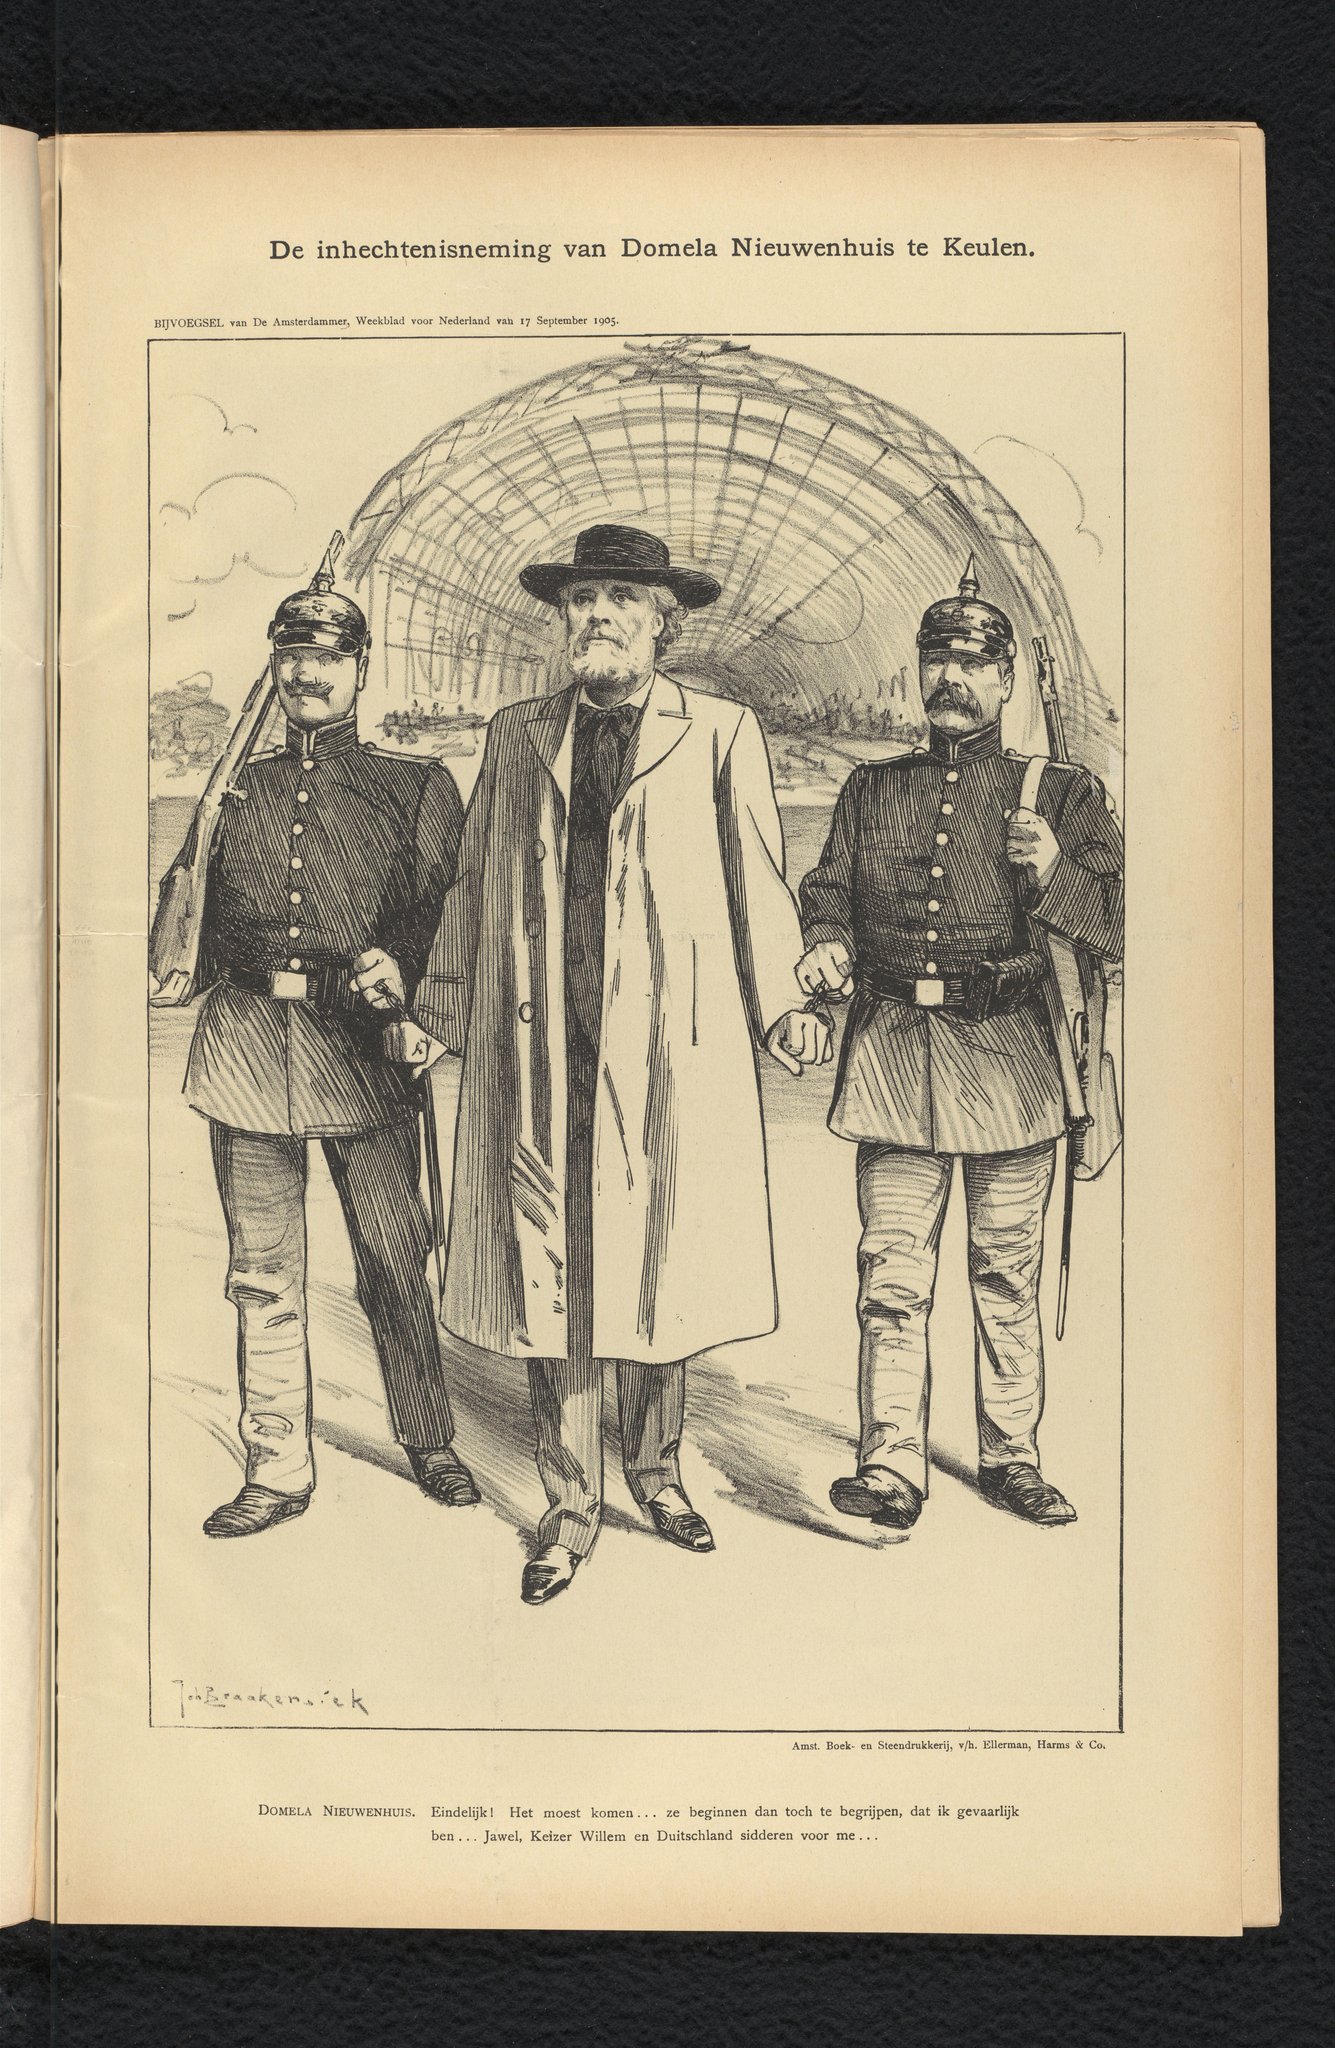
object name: cartoon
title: De inhechtenisneming van Domela Nieuwenhuis te Keulen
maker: johan braakensiek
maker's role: draughtsman, print maker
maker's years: 1858-1940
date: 1905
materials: paper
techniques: lithograph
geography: netherlands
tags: ferdinand domela nieuwenhuis, arrest (of criminal), political caricatures and satires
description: De Nederlandse anarchist Ferdinand Domela Nieuwenhuis te Keulen gearresteerd en weggeleid door twee Duitse militairen.